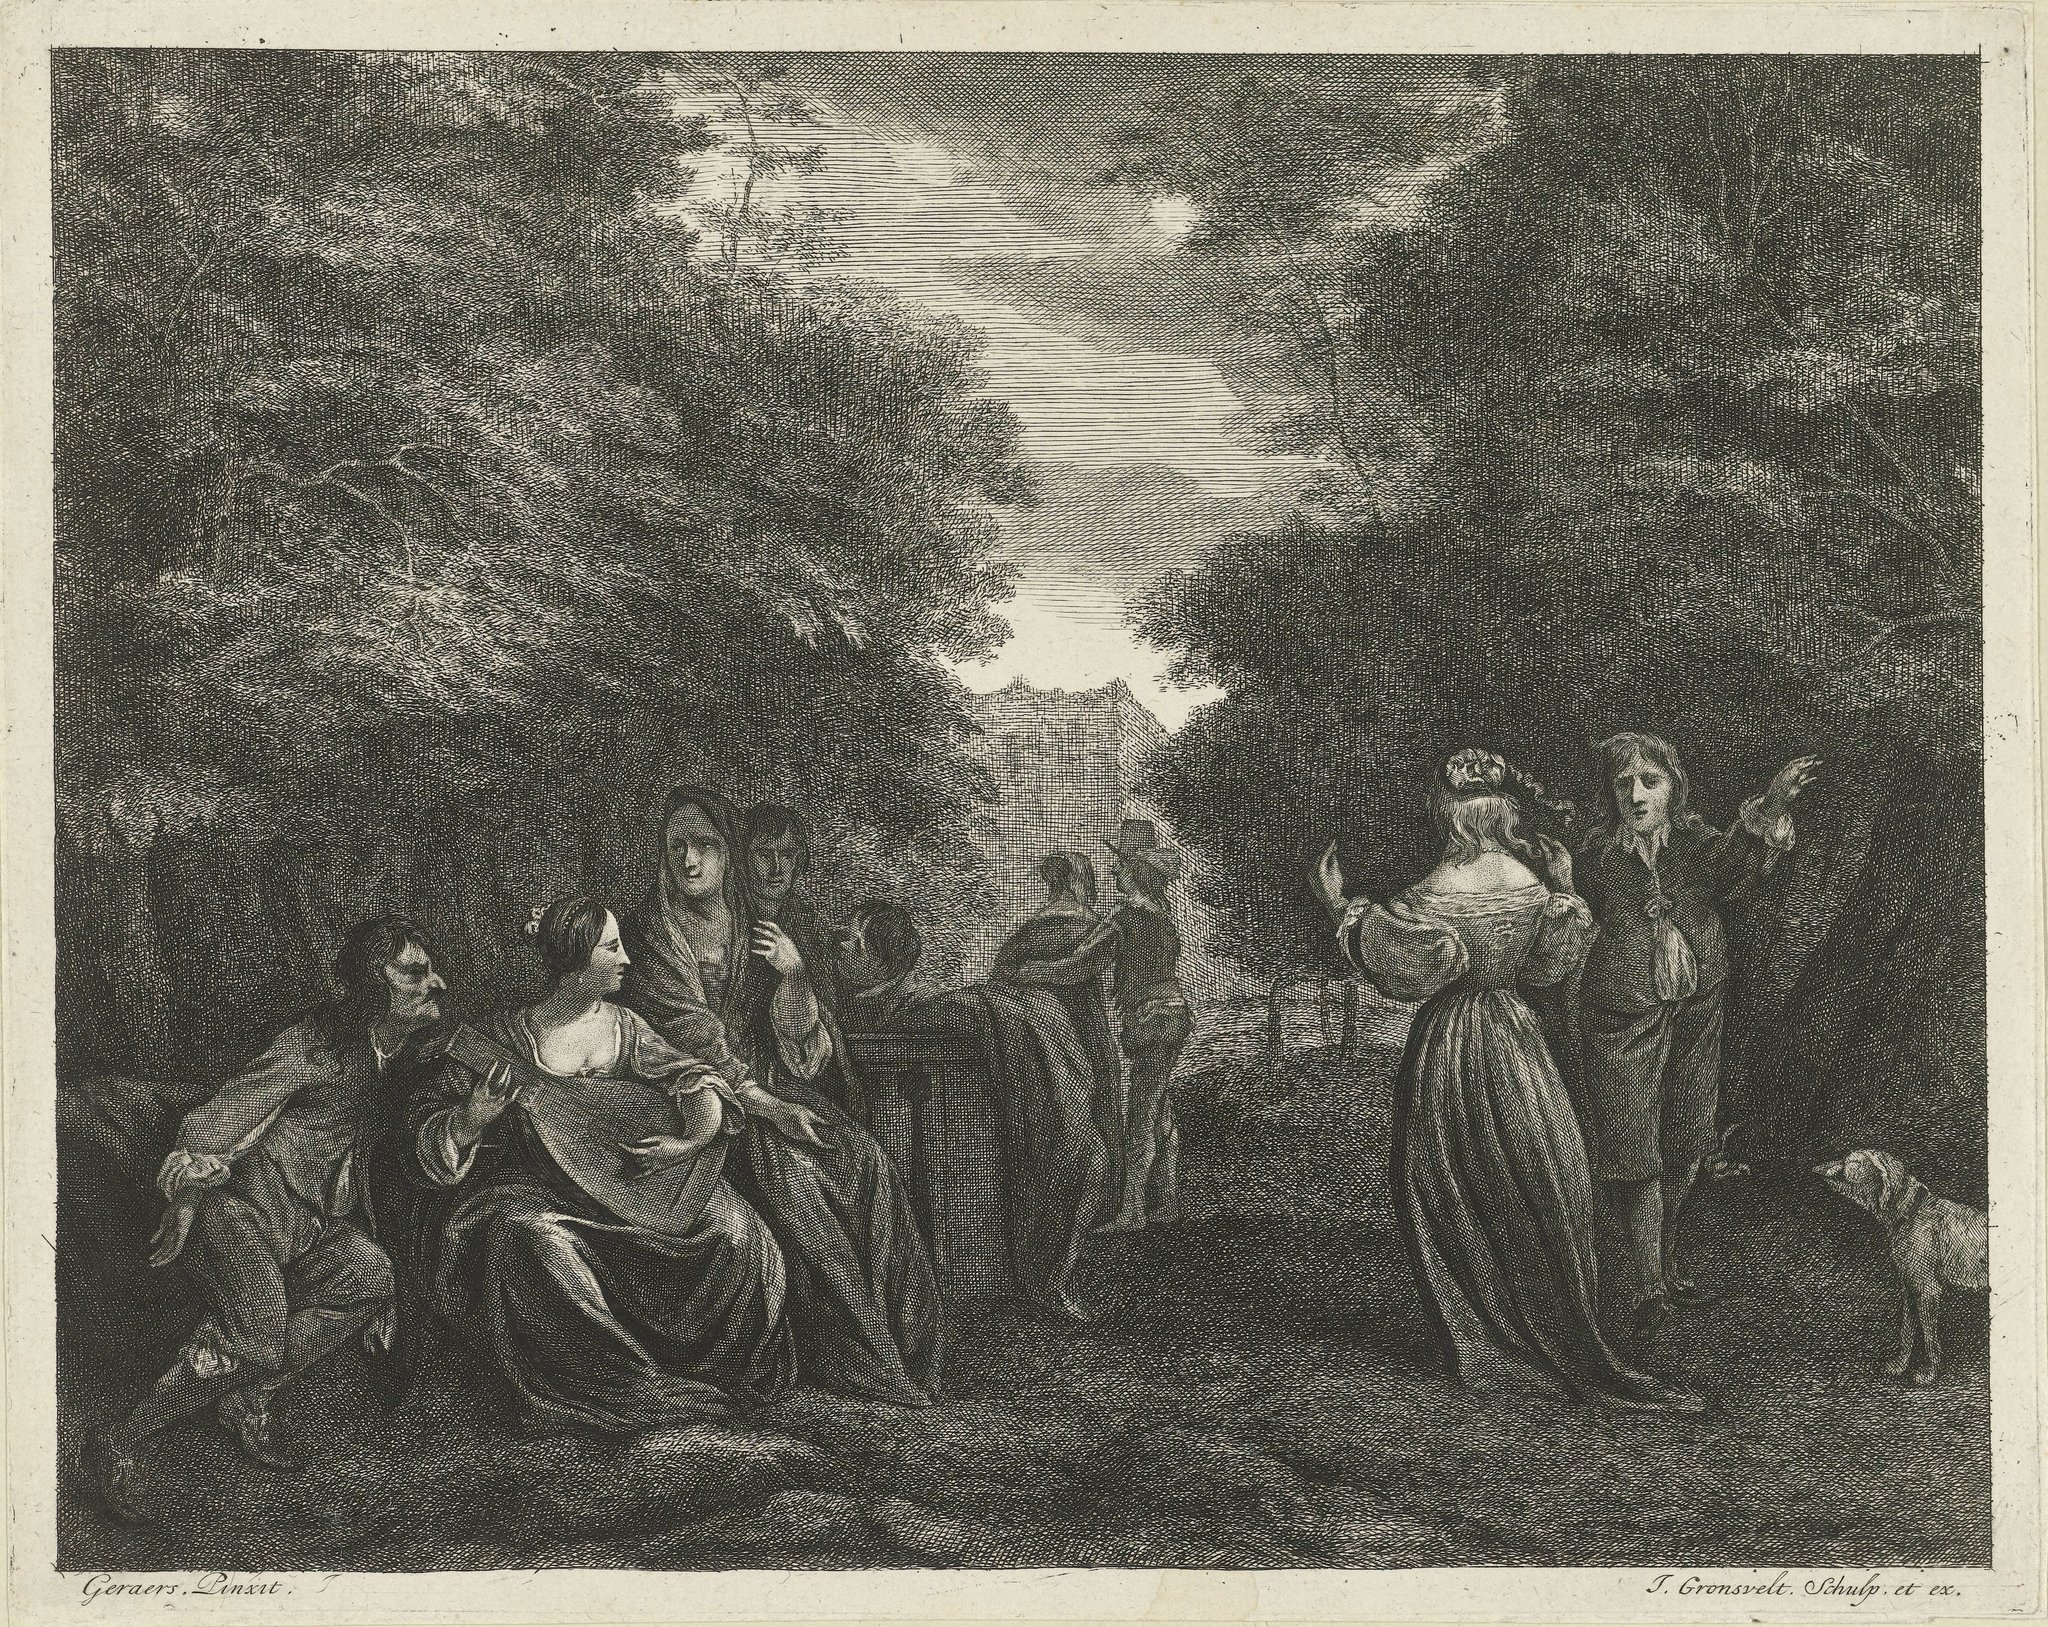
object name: print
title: Landschap met musicerend en dansend gezelschap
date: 1679-1728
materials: paper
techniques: engraving, etching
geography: amsterdam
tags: small group of musicians, chamber orchestra, jazz band - cc - 'concert champêtre'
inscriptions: collector's mark: Lugt 240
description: Landschap met links een vrouw spelend op een luit en rechts een dansend paar en een hond. In het midden op de achtergrond nog een dansend paar.